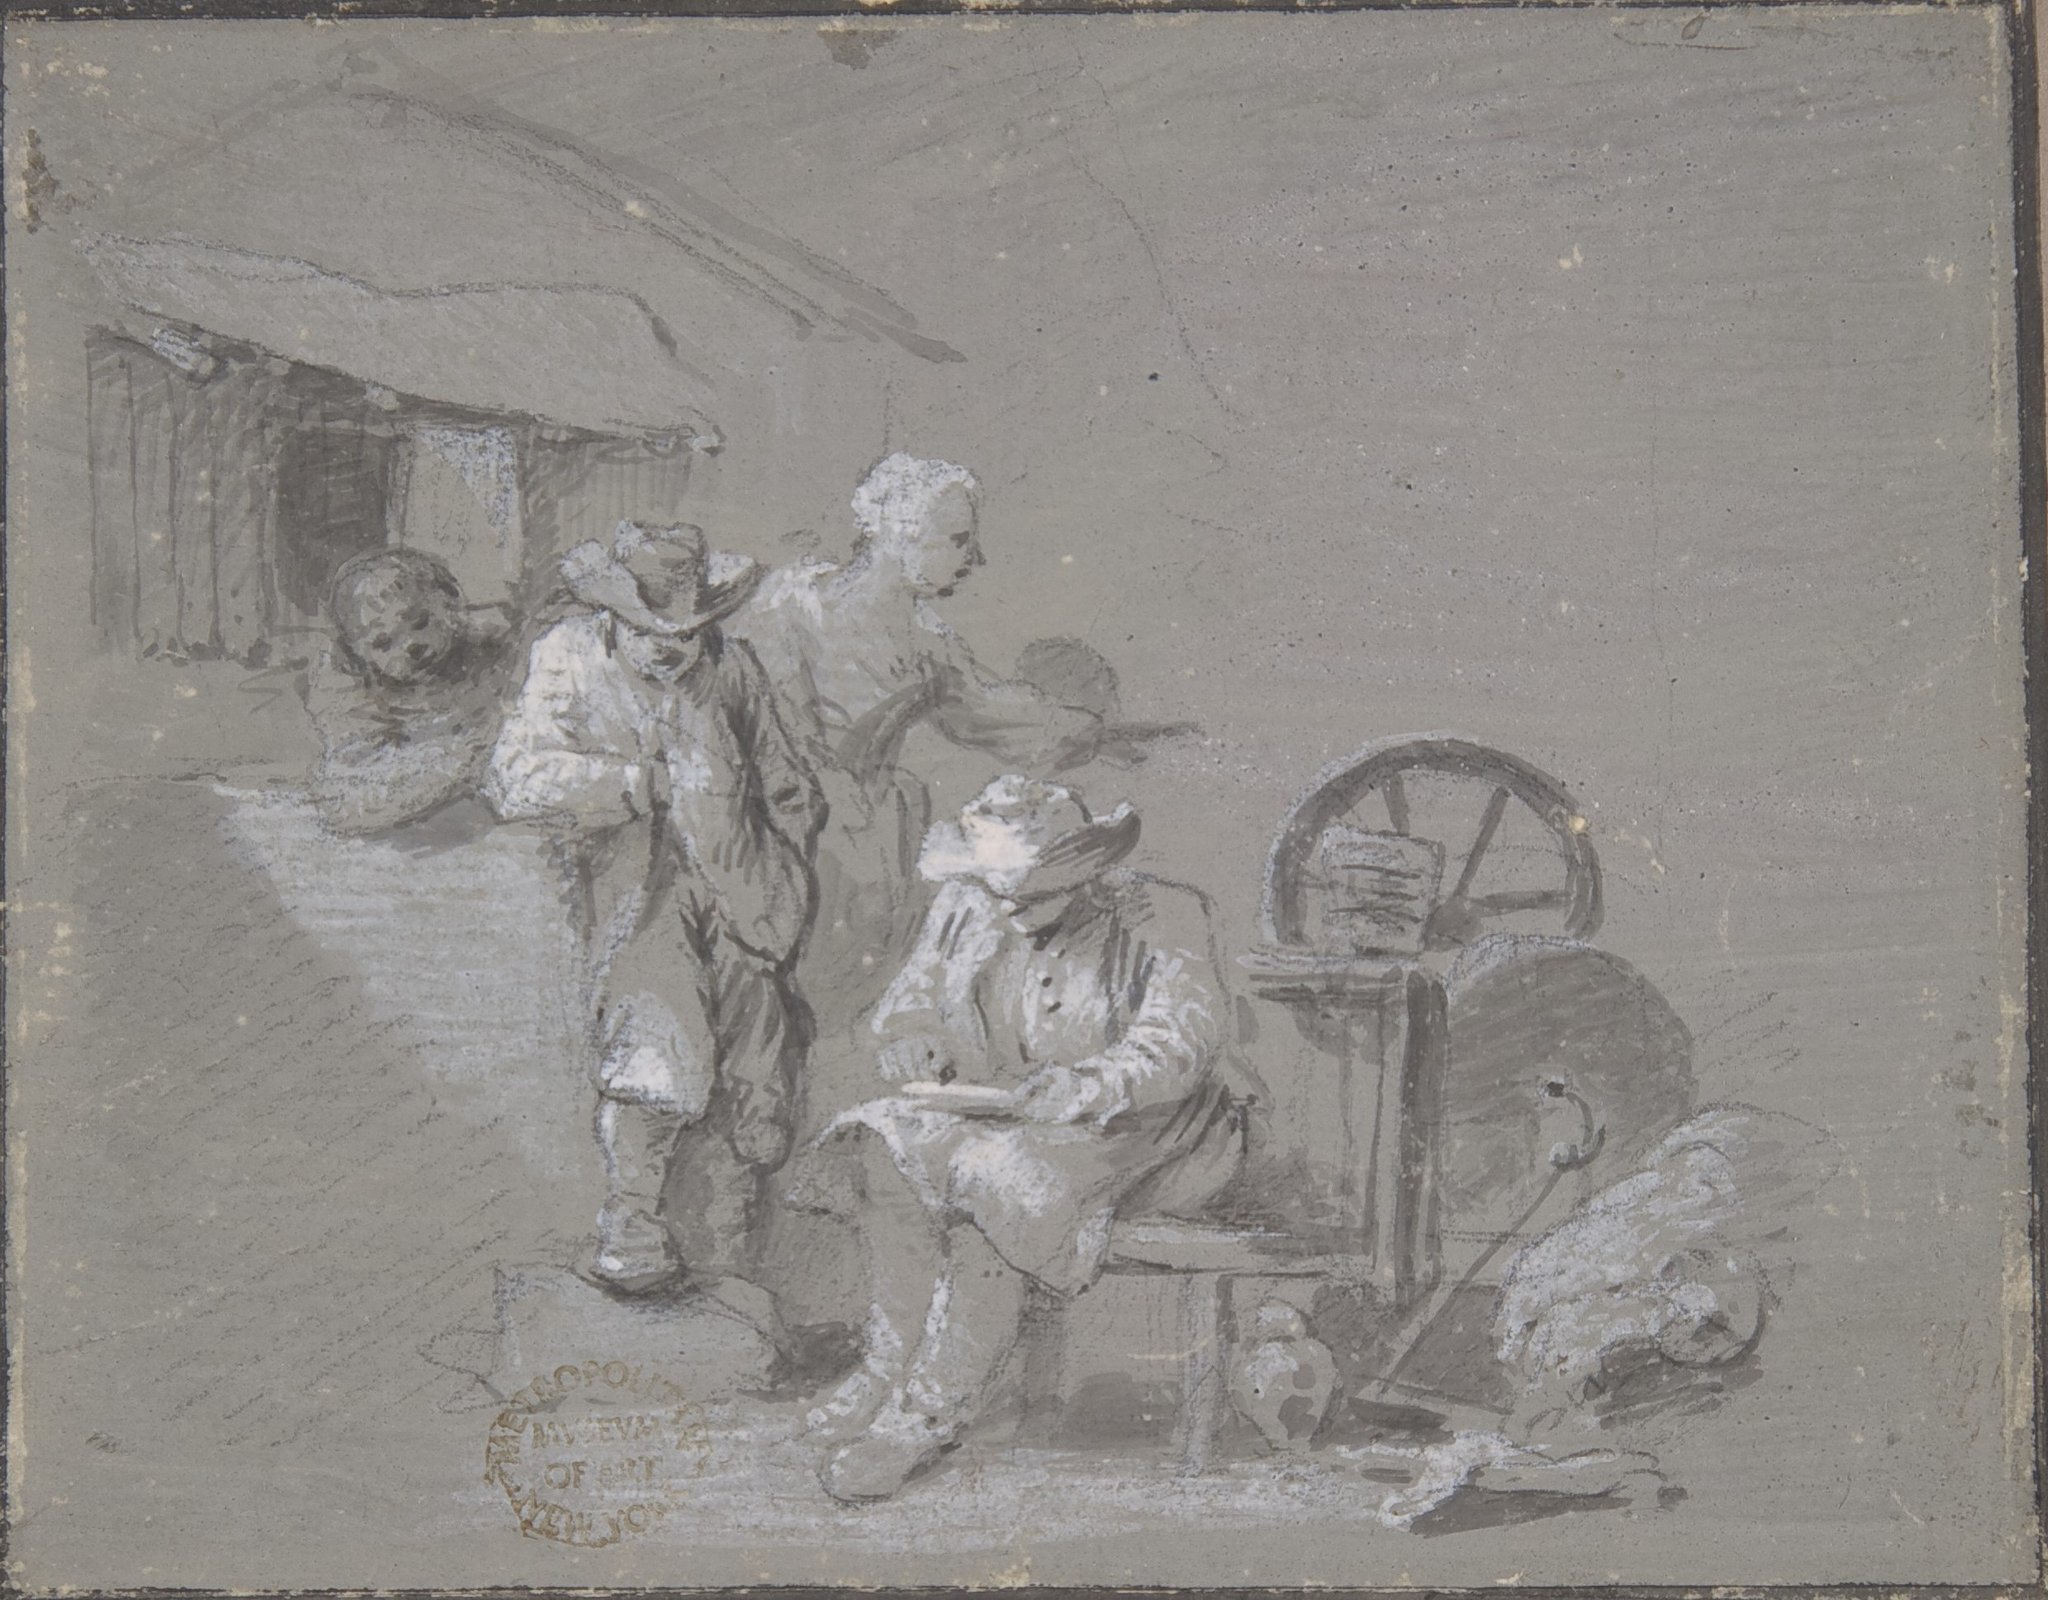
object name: drawing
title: Flemish Peasants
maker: frans boudewyns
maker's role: artist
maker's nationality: flemish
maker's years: 1720-1766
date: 1734-1766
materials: graphite, paper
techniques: brush, heightening, wash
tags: men,women